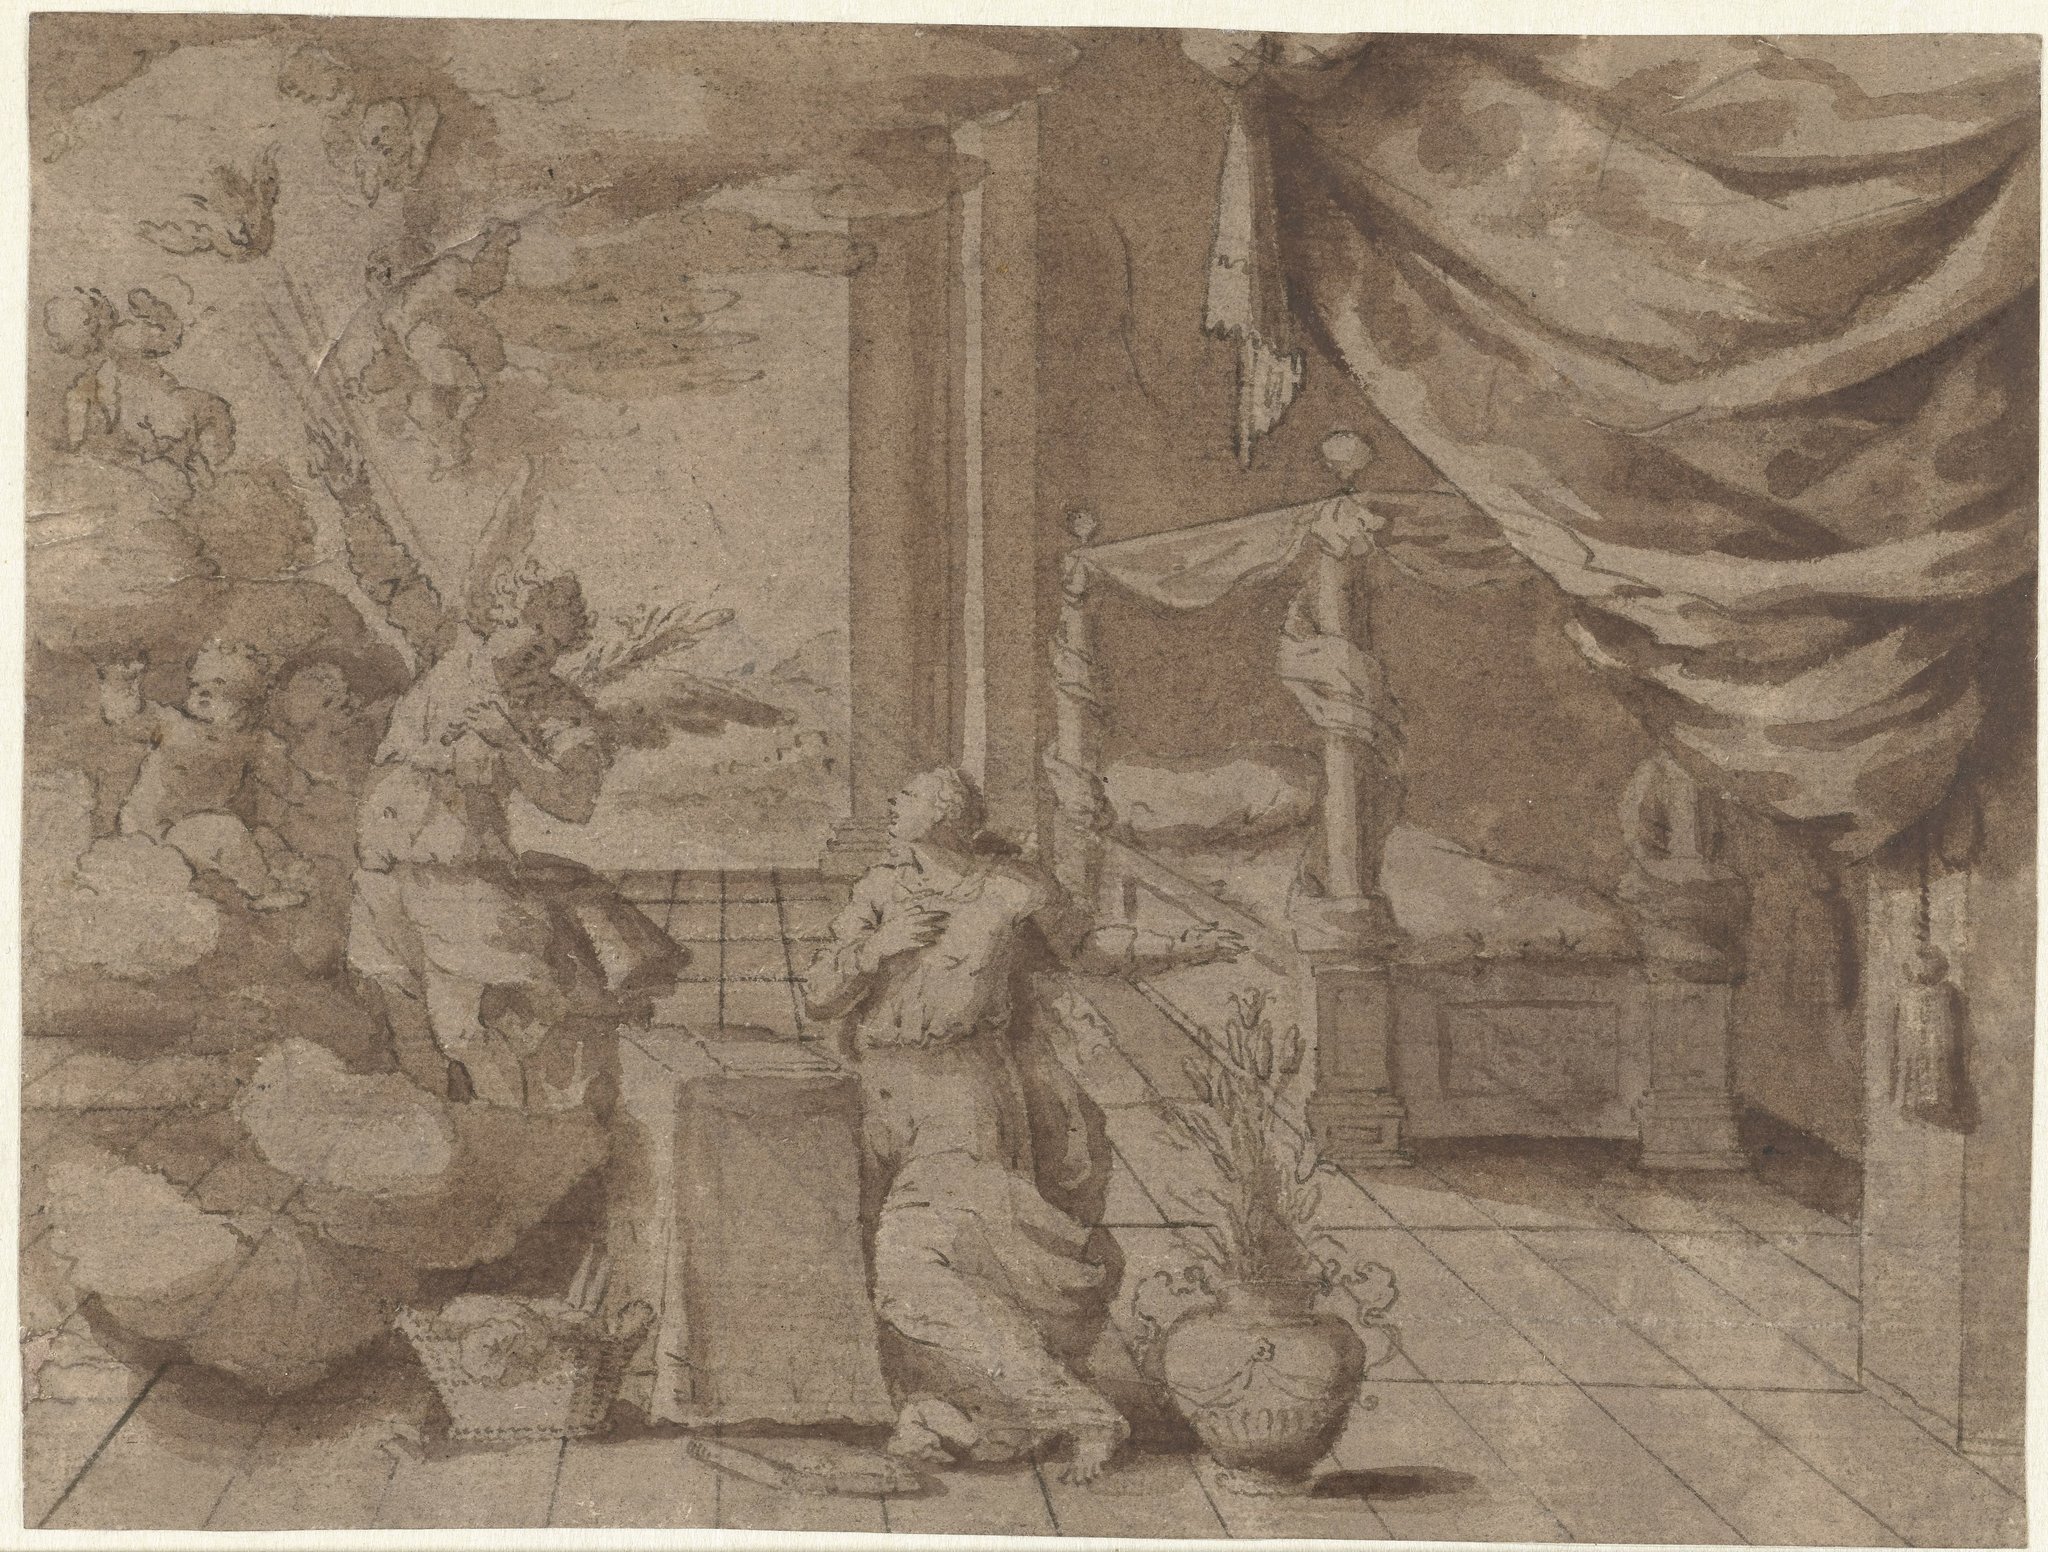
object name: drawing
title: De Annunciatie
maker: Anonymous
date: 1600-1699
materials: chalk, graphite, ink, paper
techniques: brush, pen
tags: the annunciation: mary, usually reading, is visited by the angel (sometimes a woman overhears the conversation)